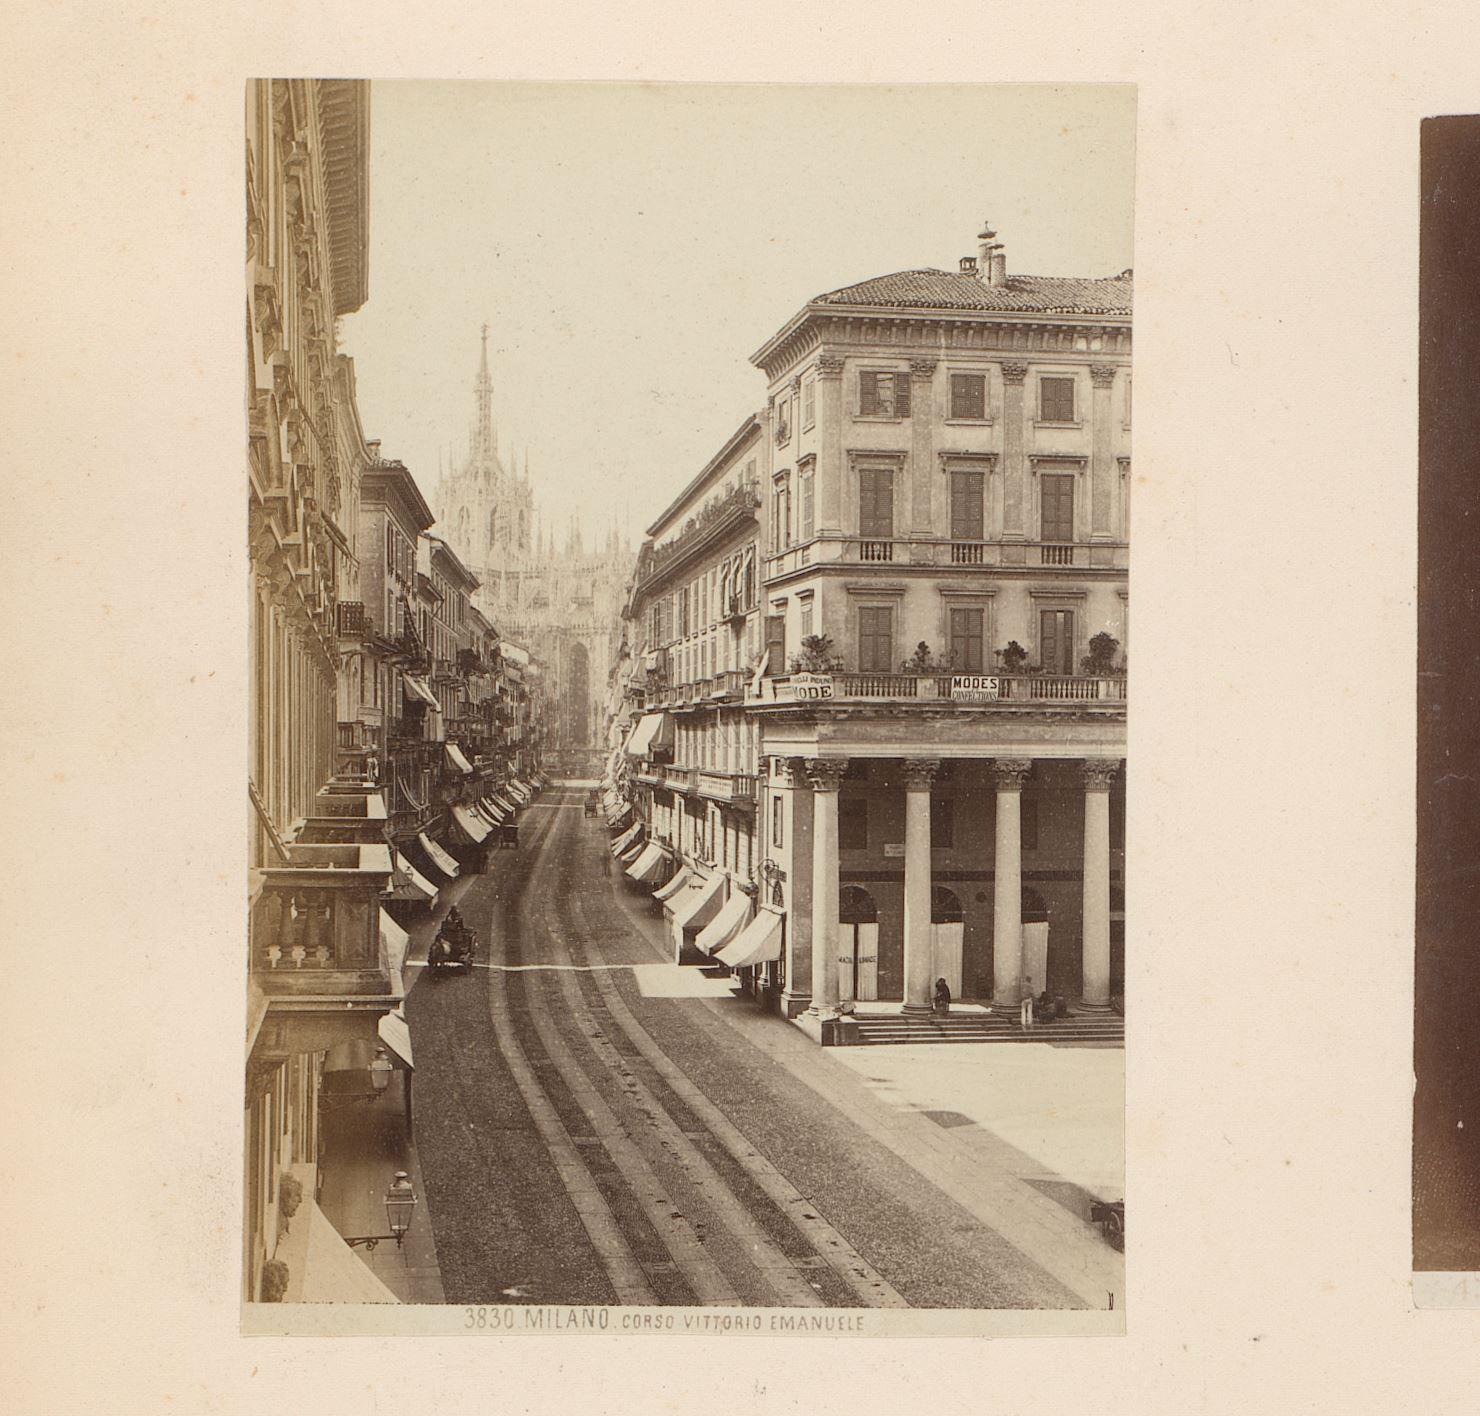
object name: album leaf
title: Milano. Corso Vittorio Emanuele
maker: Anonymous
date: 1860-1890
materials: paper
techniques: albumen print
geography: milan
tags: church (exterior), street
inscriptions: number: ‘3830’